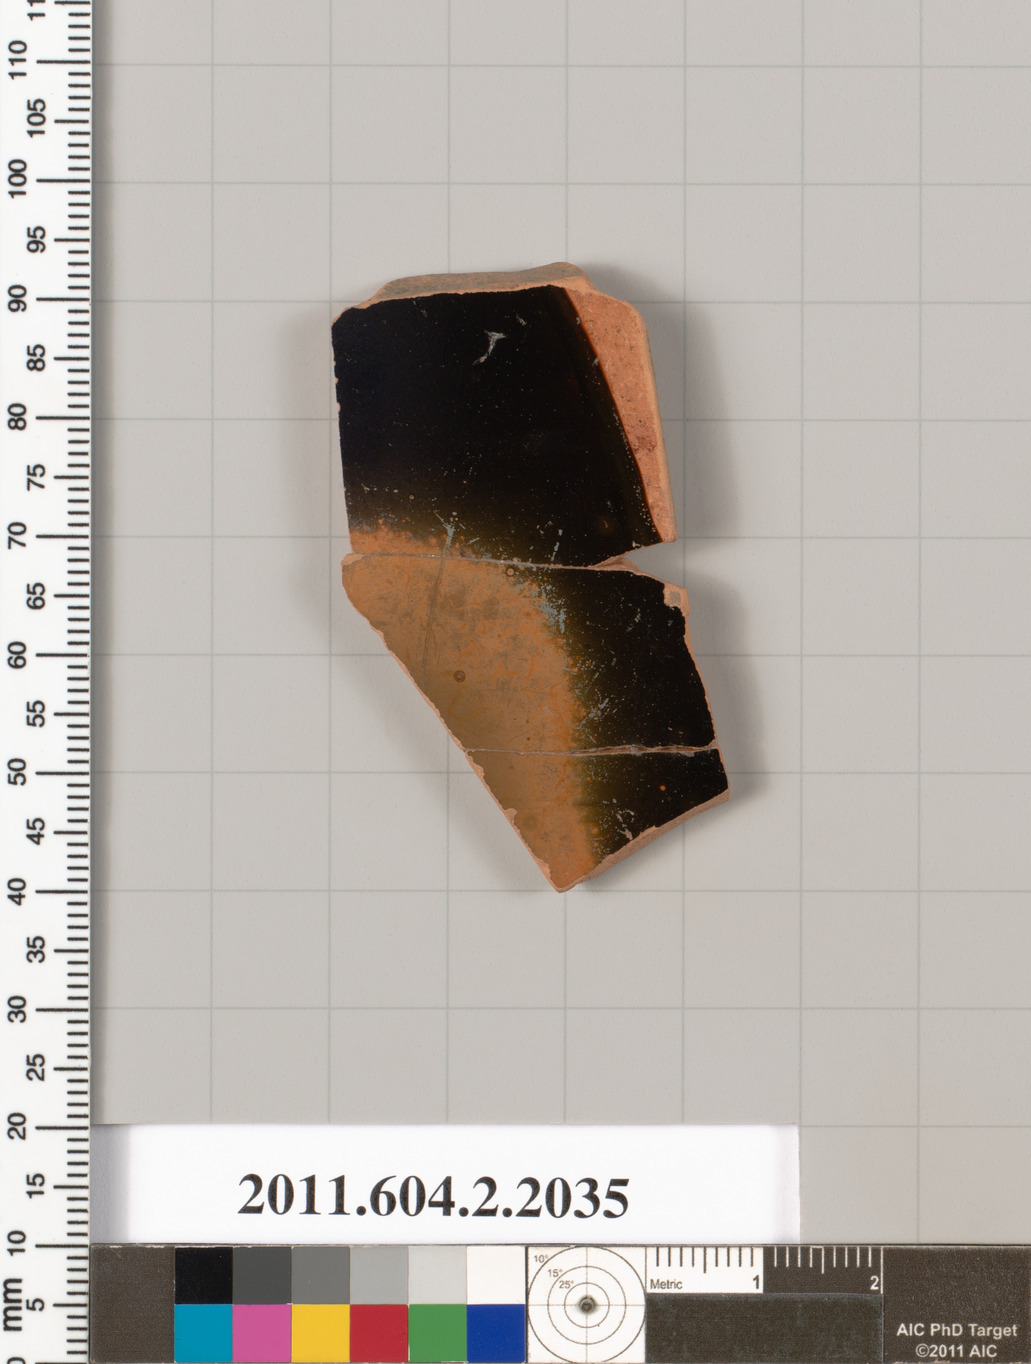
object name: pot fragment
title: Terracotta fragment of a pot; unglazed on the inside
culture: greek, attic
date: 600-501 BCE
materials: terracotta